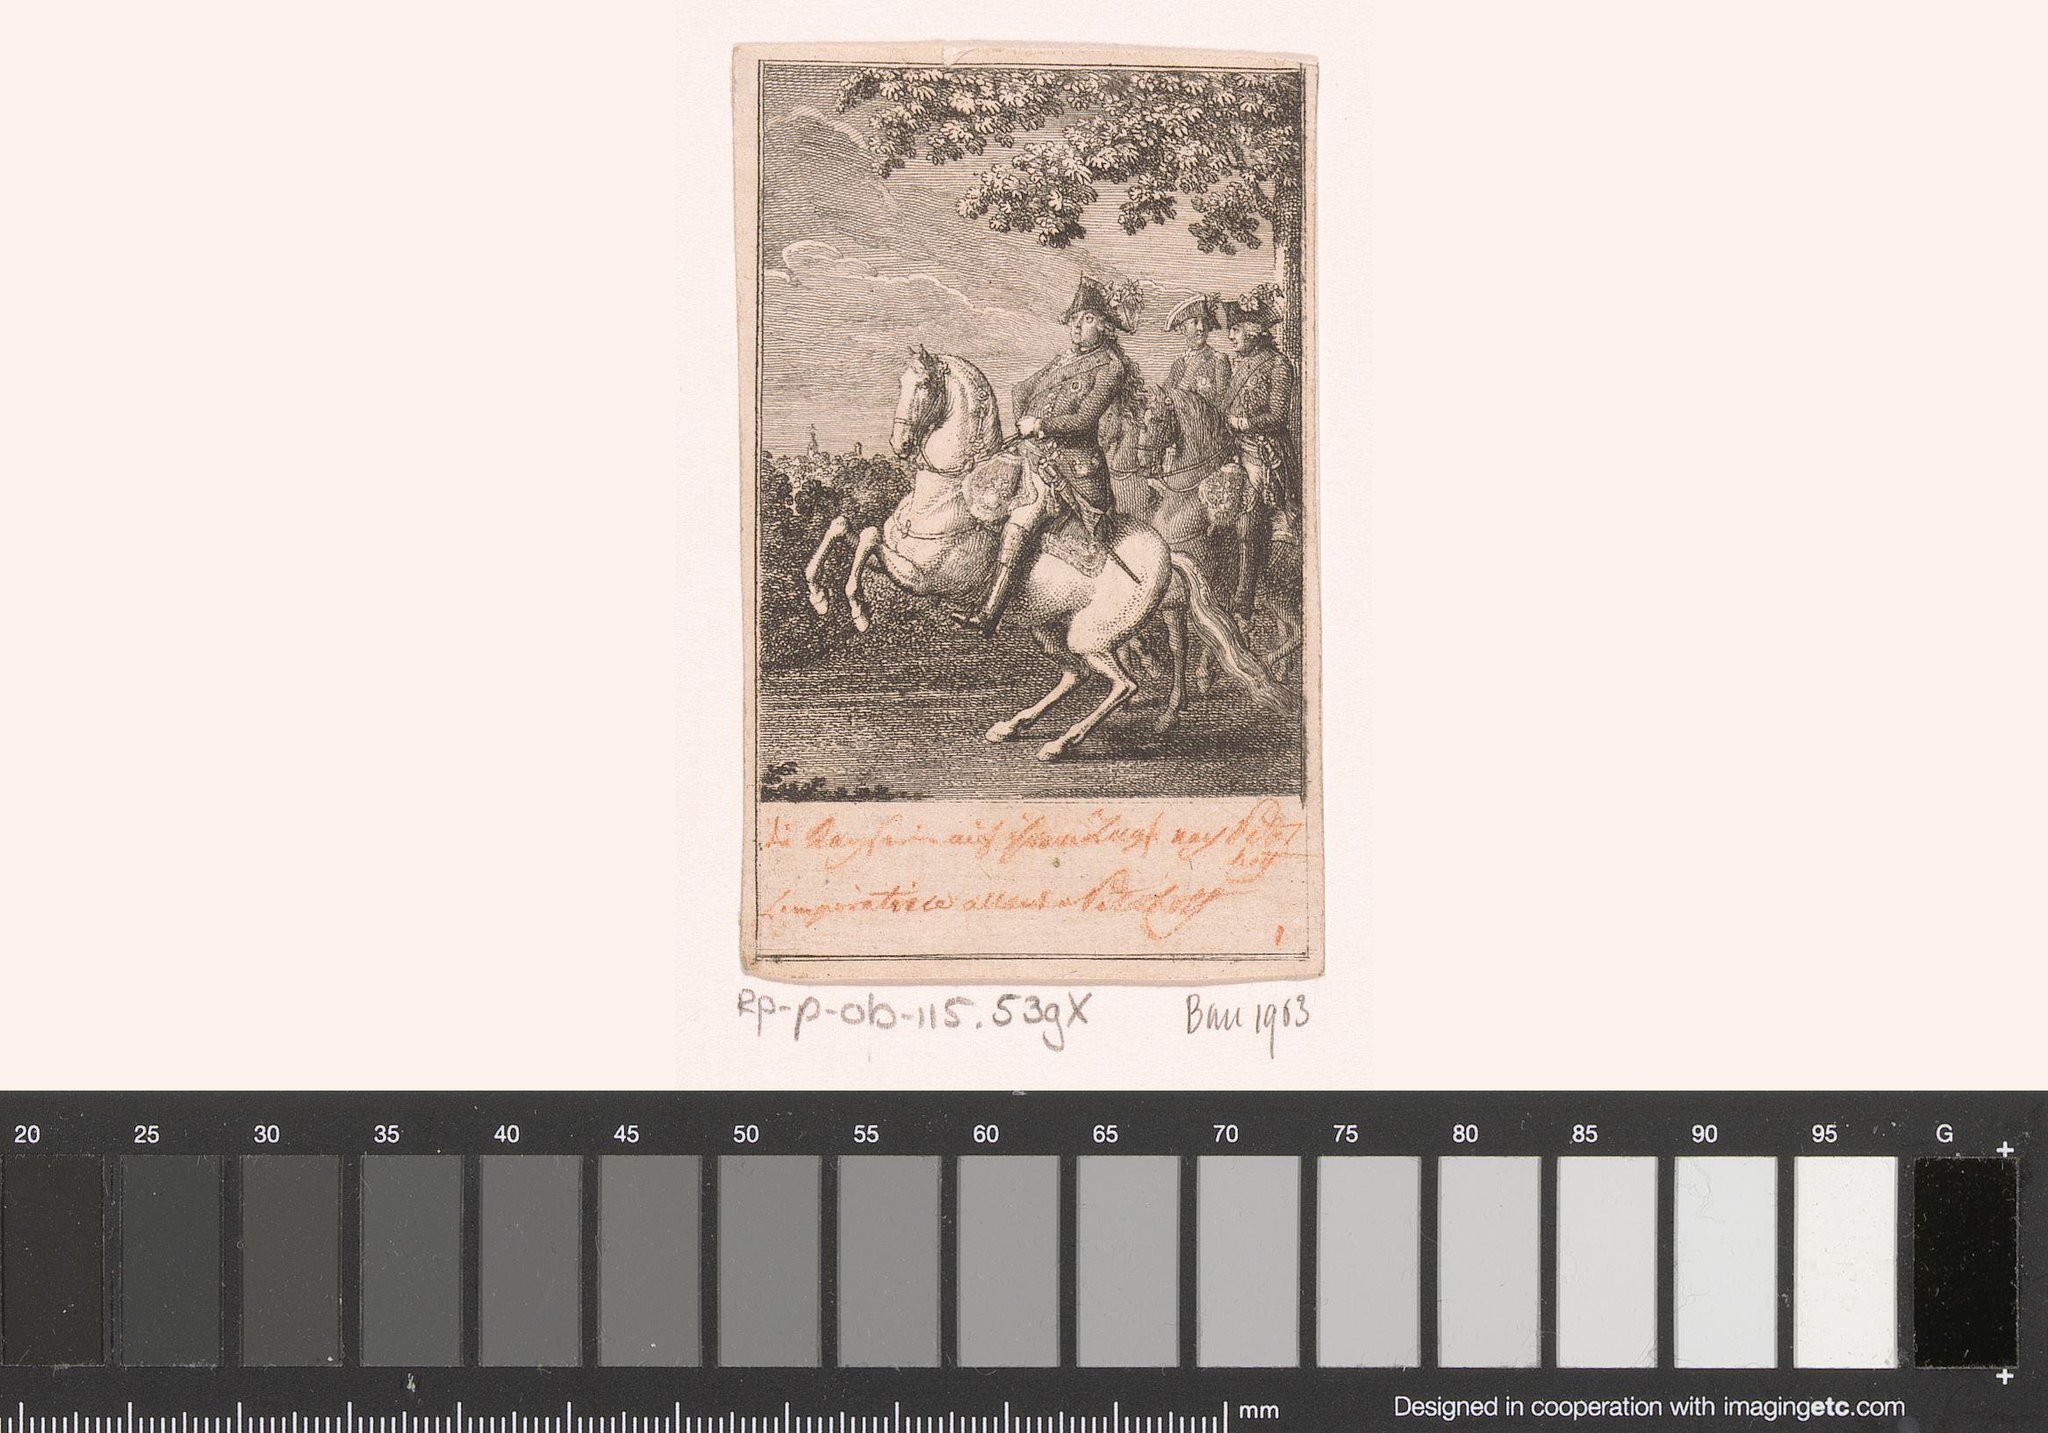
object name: print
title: Catharina de Grote verkleed als luitenant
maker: daniel nikolaus chodowiecki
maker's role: draughtsman, print maker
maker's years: 1726-1801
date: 1797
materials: paper, pencil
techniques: etching, writing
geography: berlin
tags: catharina de grote, riding a horse, ass, or mule; rider, horseman, woman dressed as man, travesty, history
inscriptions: collector's mark: Lugt 2228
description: Latere staat gebruikt voor: Historisch-genealogischer Kalender auf das Gemeinjahr 1798. Katharina II. Ein historischer Versuch (...). Berlijn: Johann Friedrich Unger, [1797].